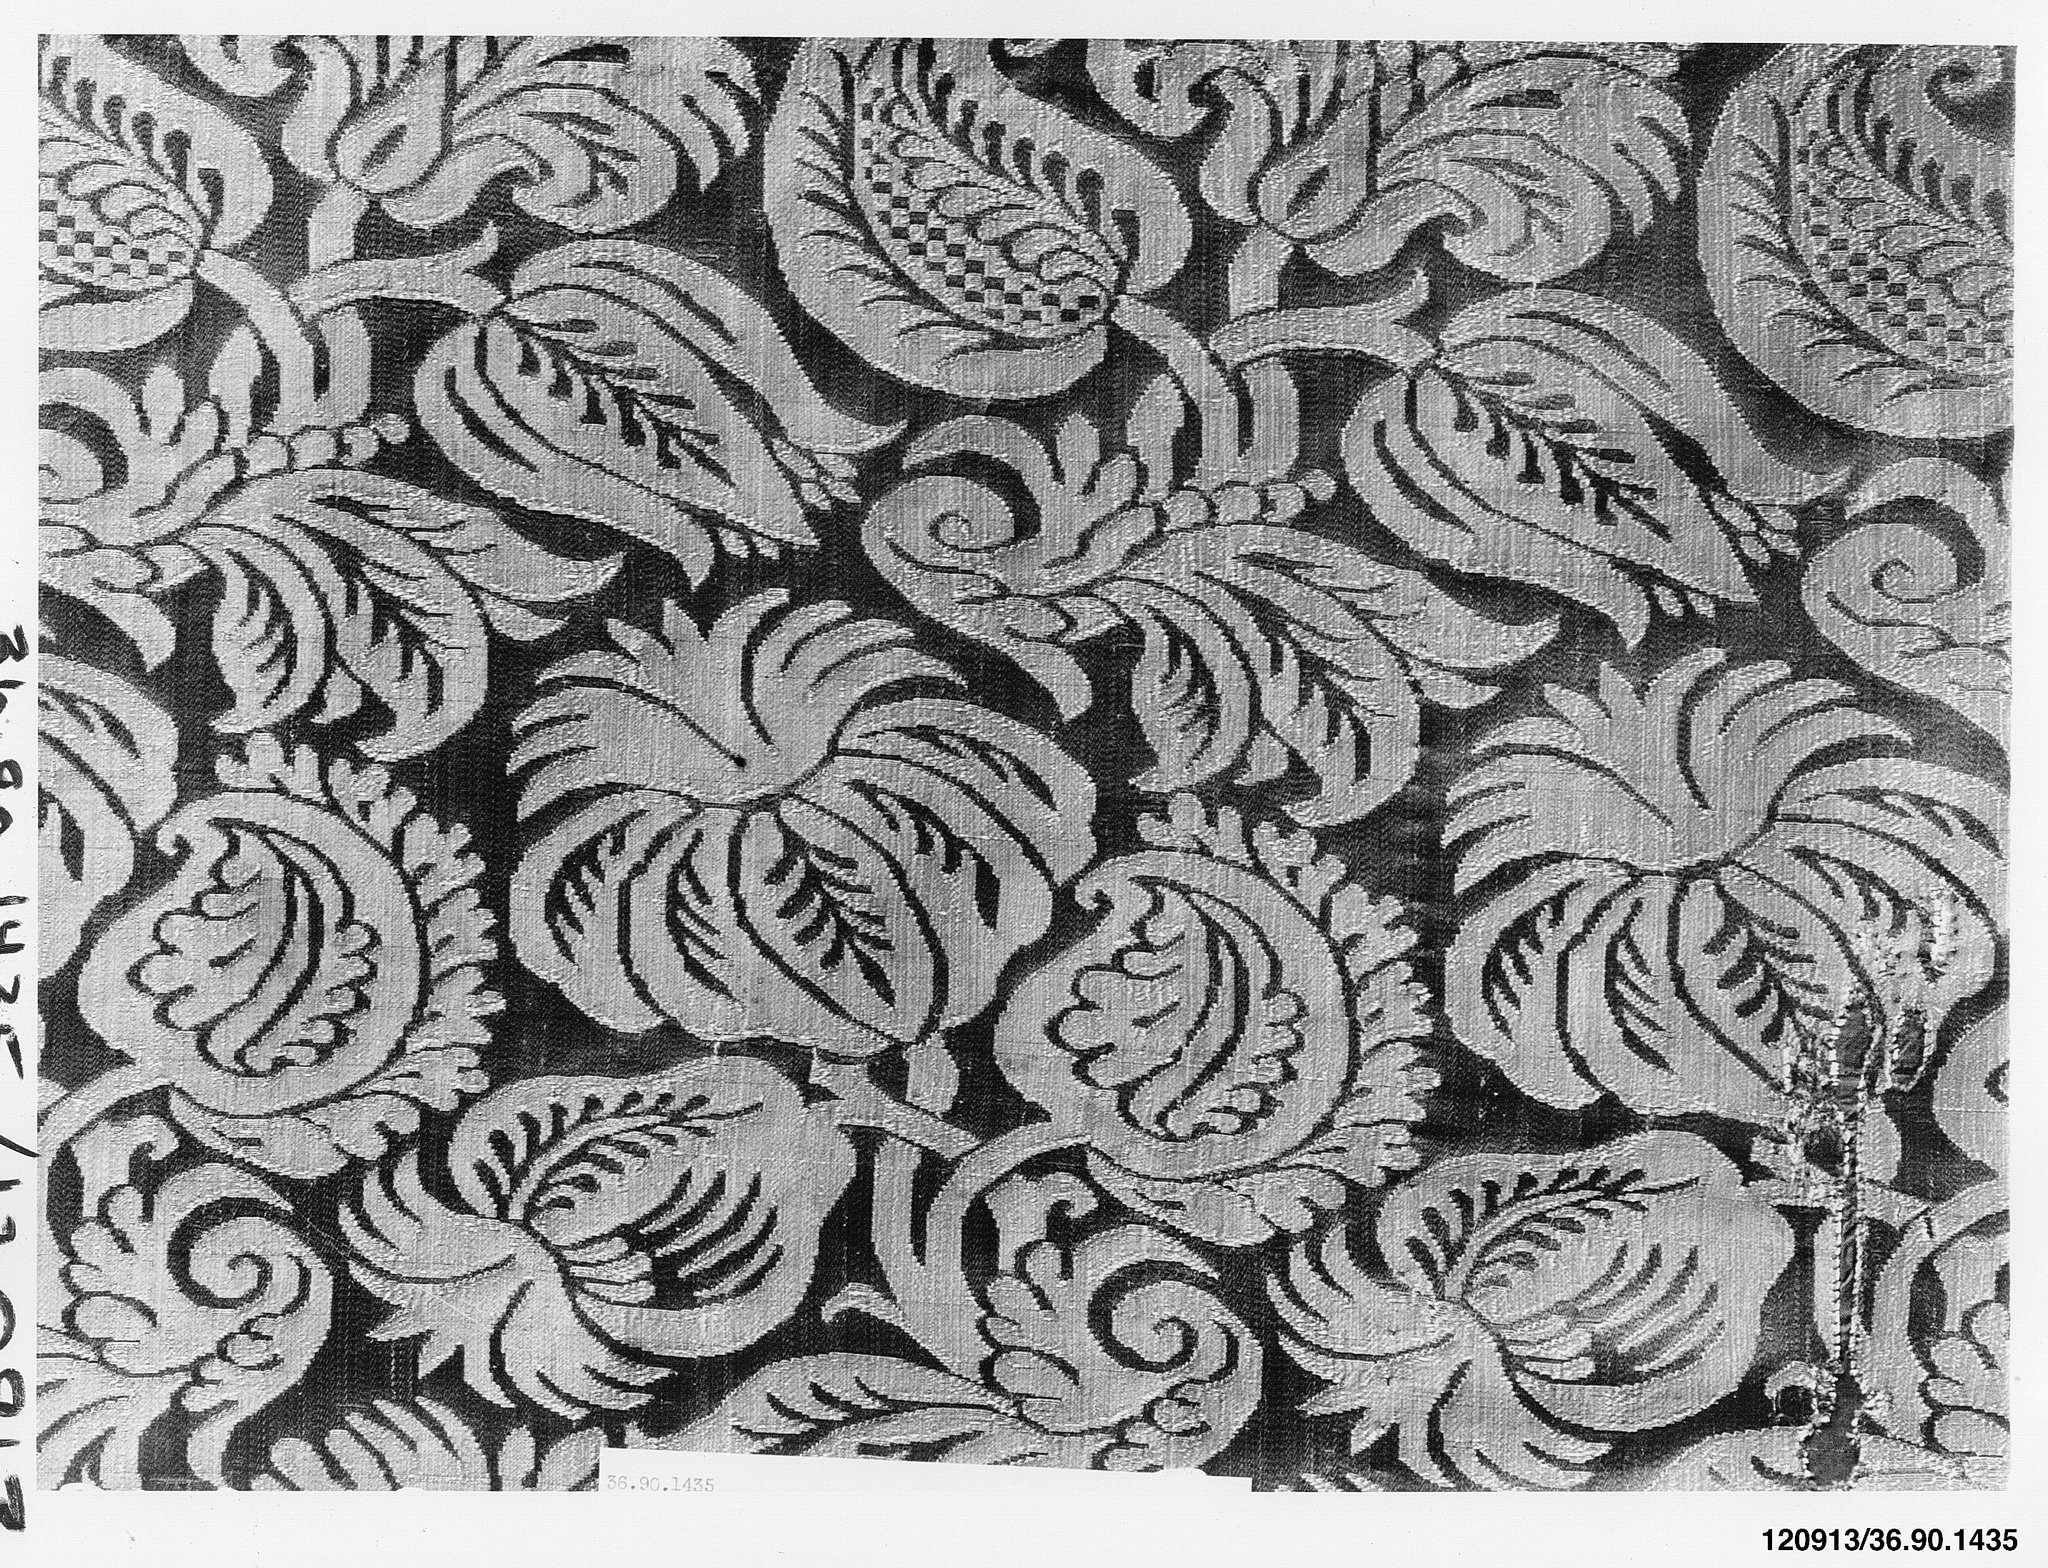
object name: piece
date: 1601-1700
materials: silk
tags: flowers,leaves